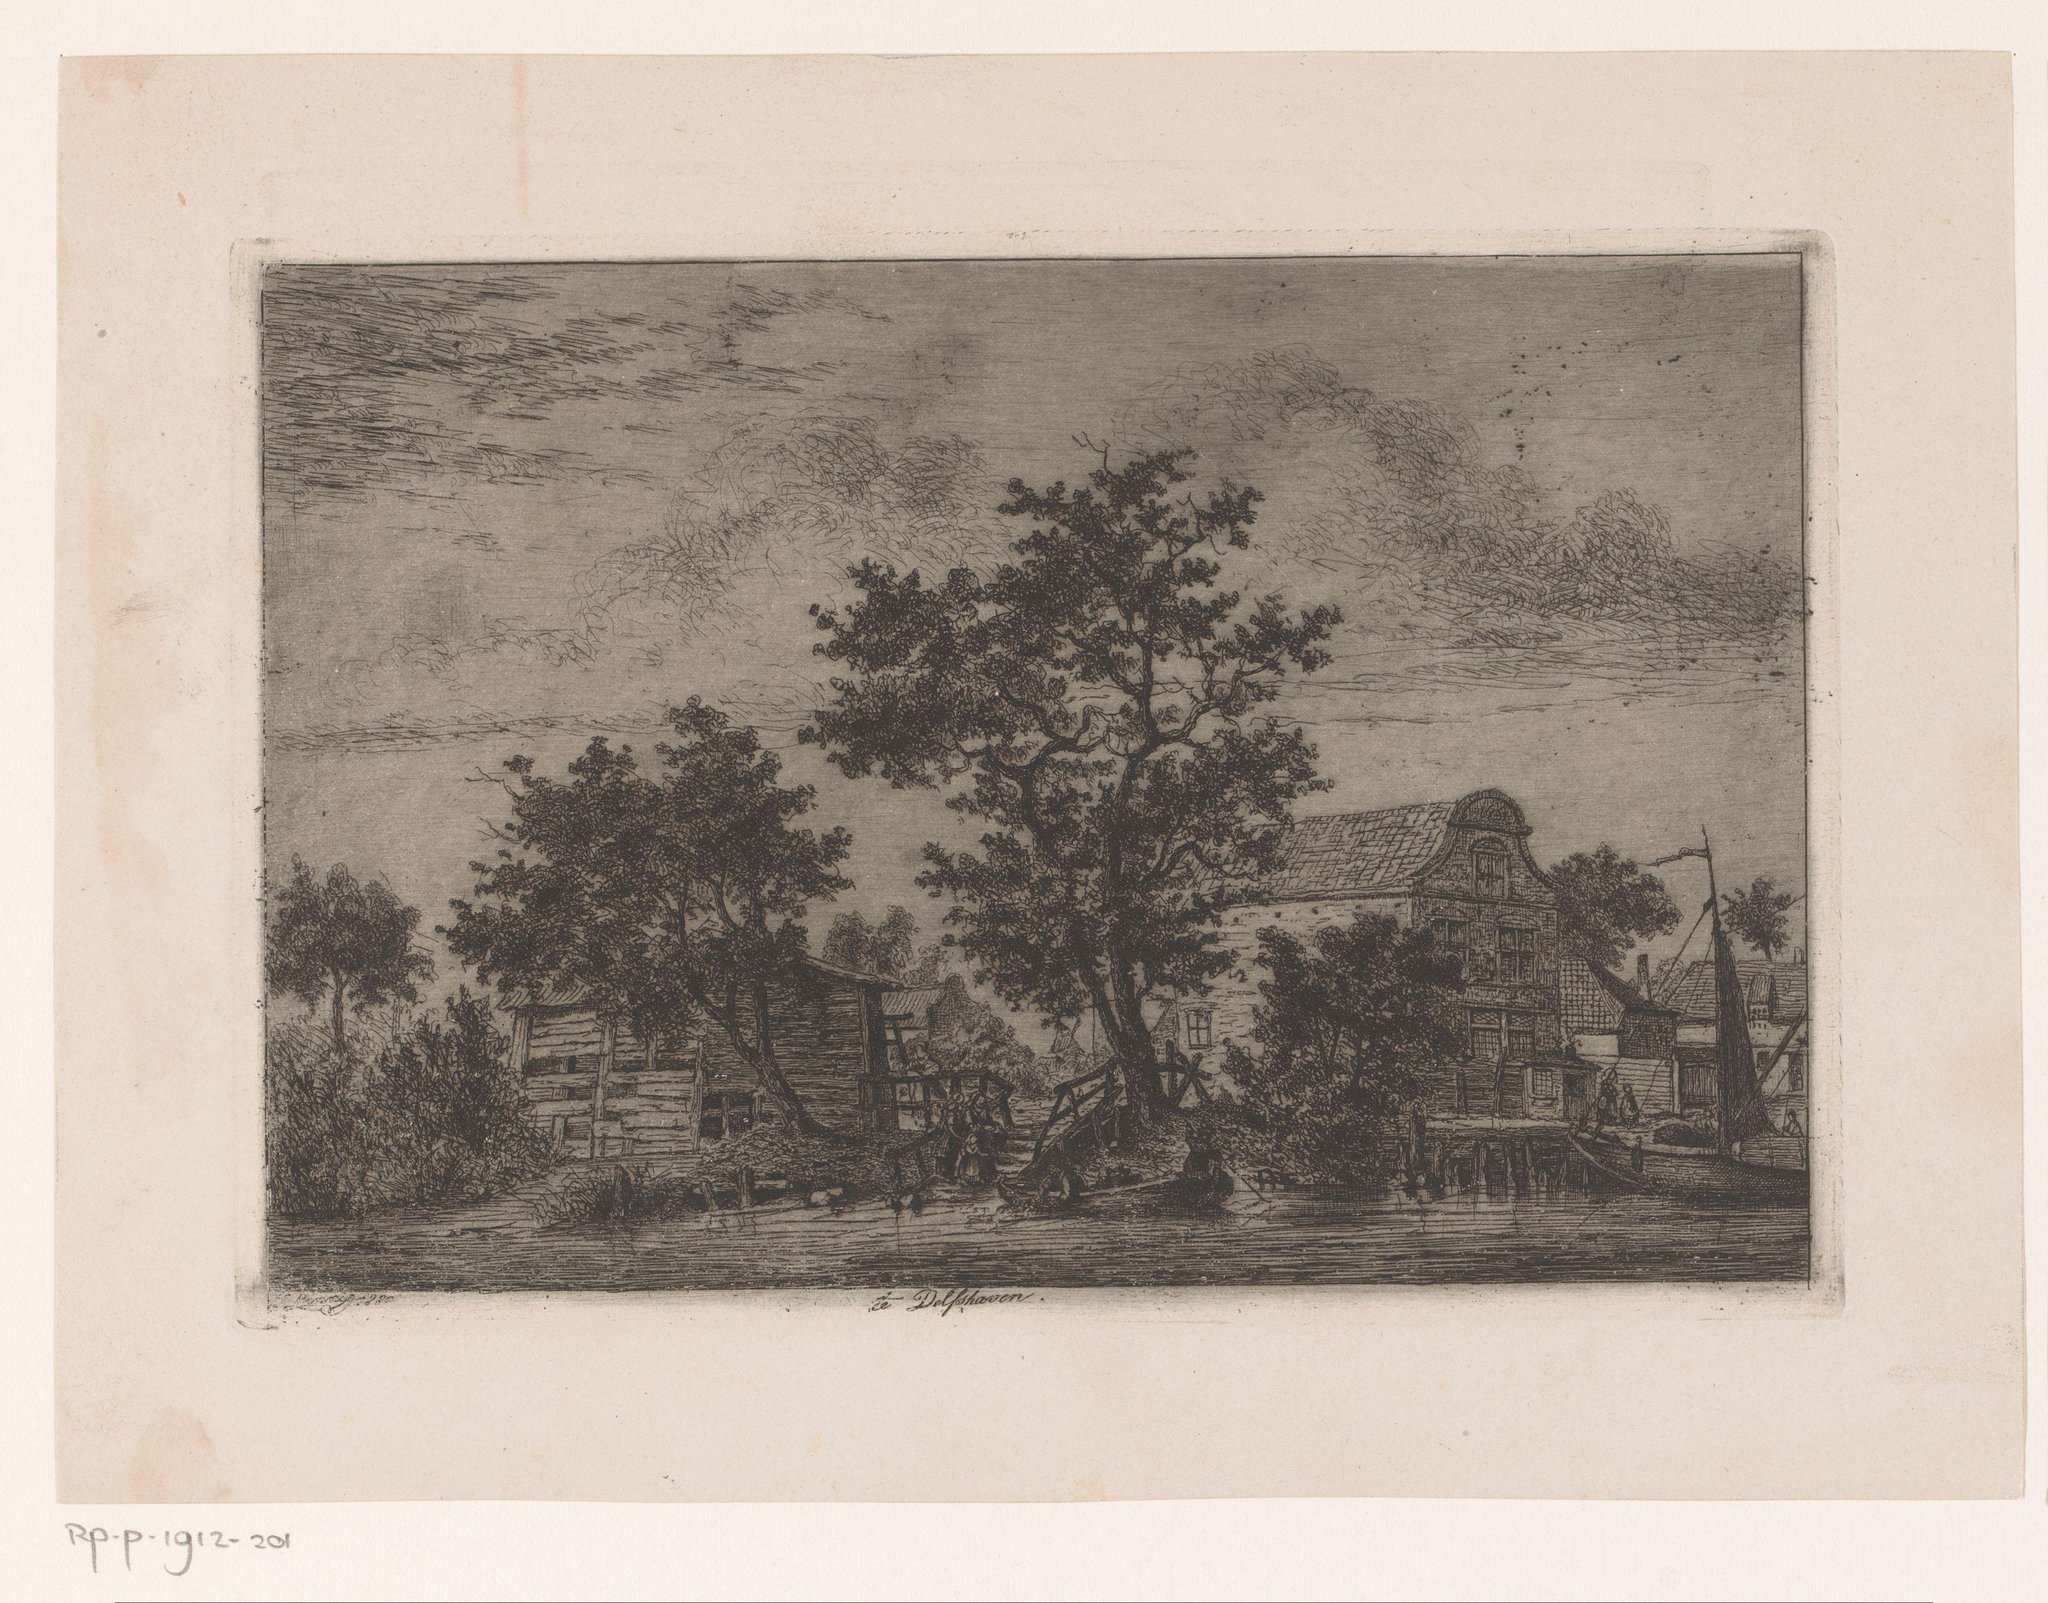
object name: print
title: Gezicht op Delfshaven vanaf het water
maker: jean théodore joseph linnig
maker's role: draughtsman, print maker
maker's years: 1815-1891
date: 1880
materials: paper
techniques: etching, intaglio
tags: warehouse (~ harbour), sailing-ship, sailing-boat, canals, waters (in city), delfshaven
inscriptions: collector's mark: Lugt 2228